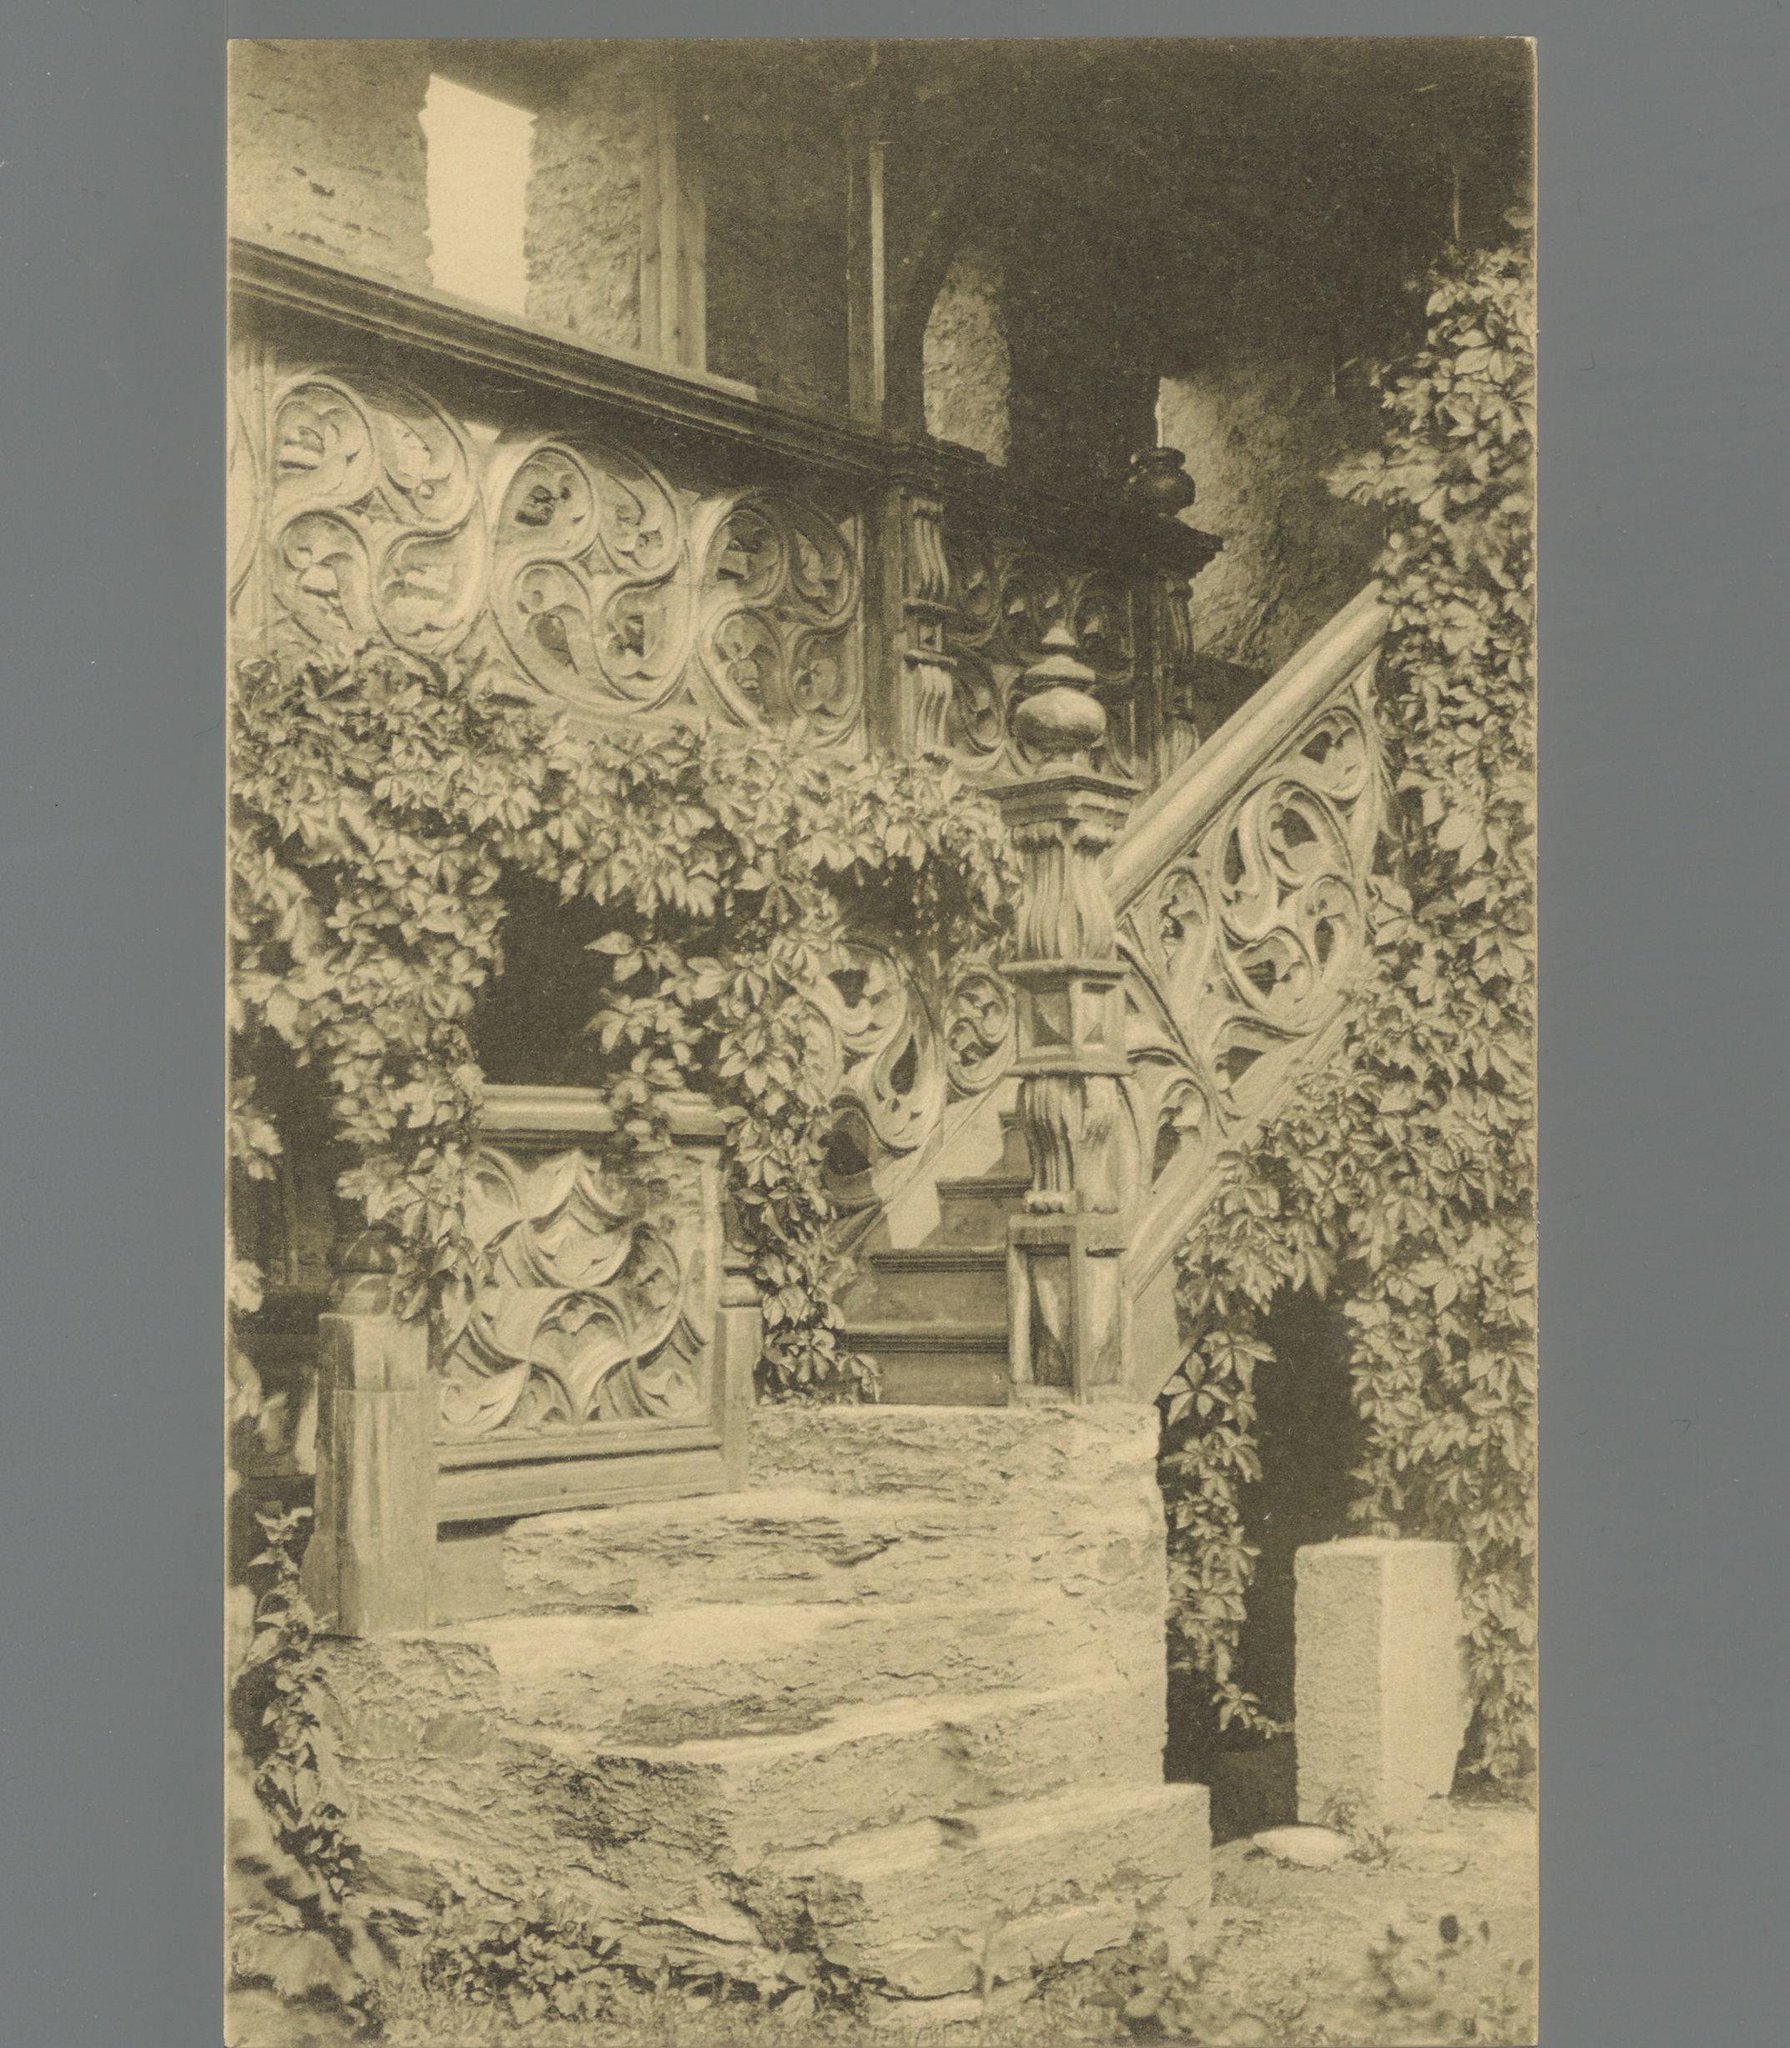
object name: ansichtkaart, prentbriefkaart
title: Burg Lauenstein (thüringisch-fränkische Grenzwarte). Aufstieg zum Wehrgang im Inneren Burghof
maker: Anonymous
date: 1905-1930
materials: cardboard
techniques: photograph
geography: ludwigsstadt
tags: castle, back steps